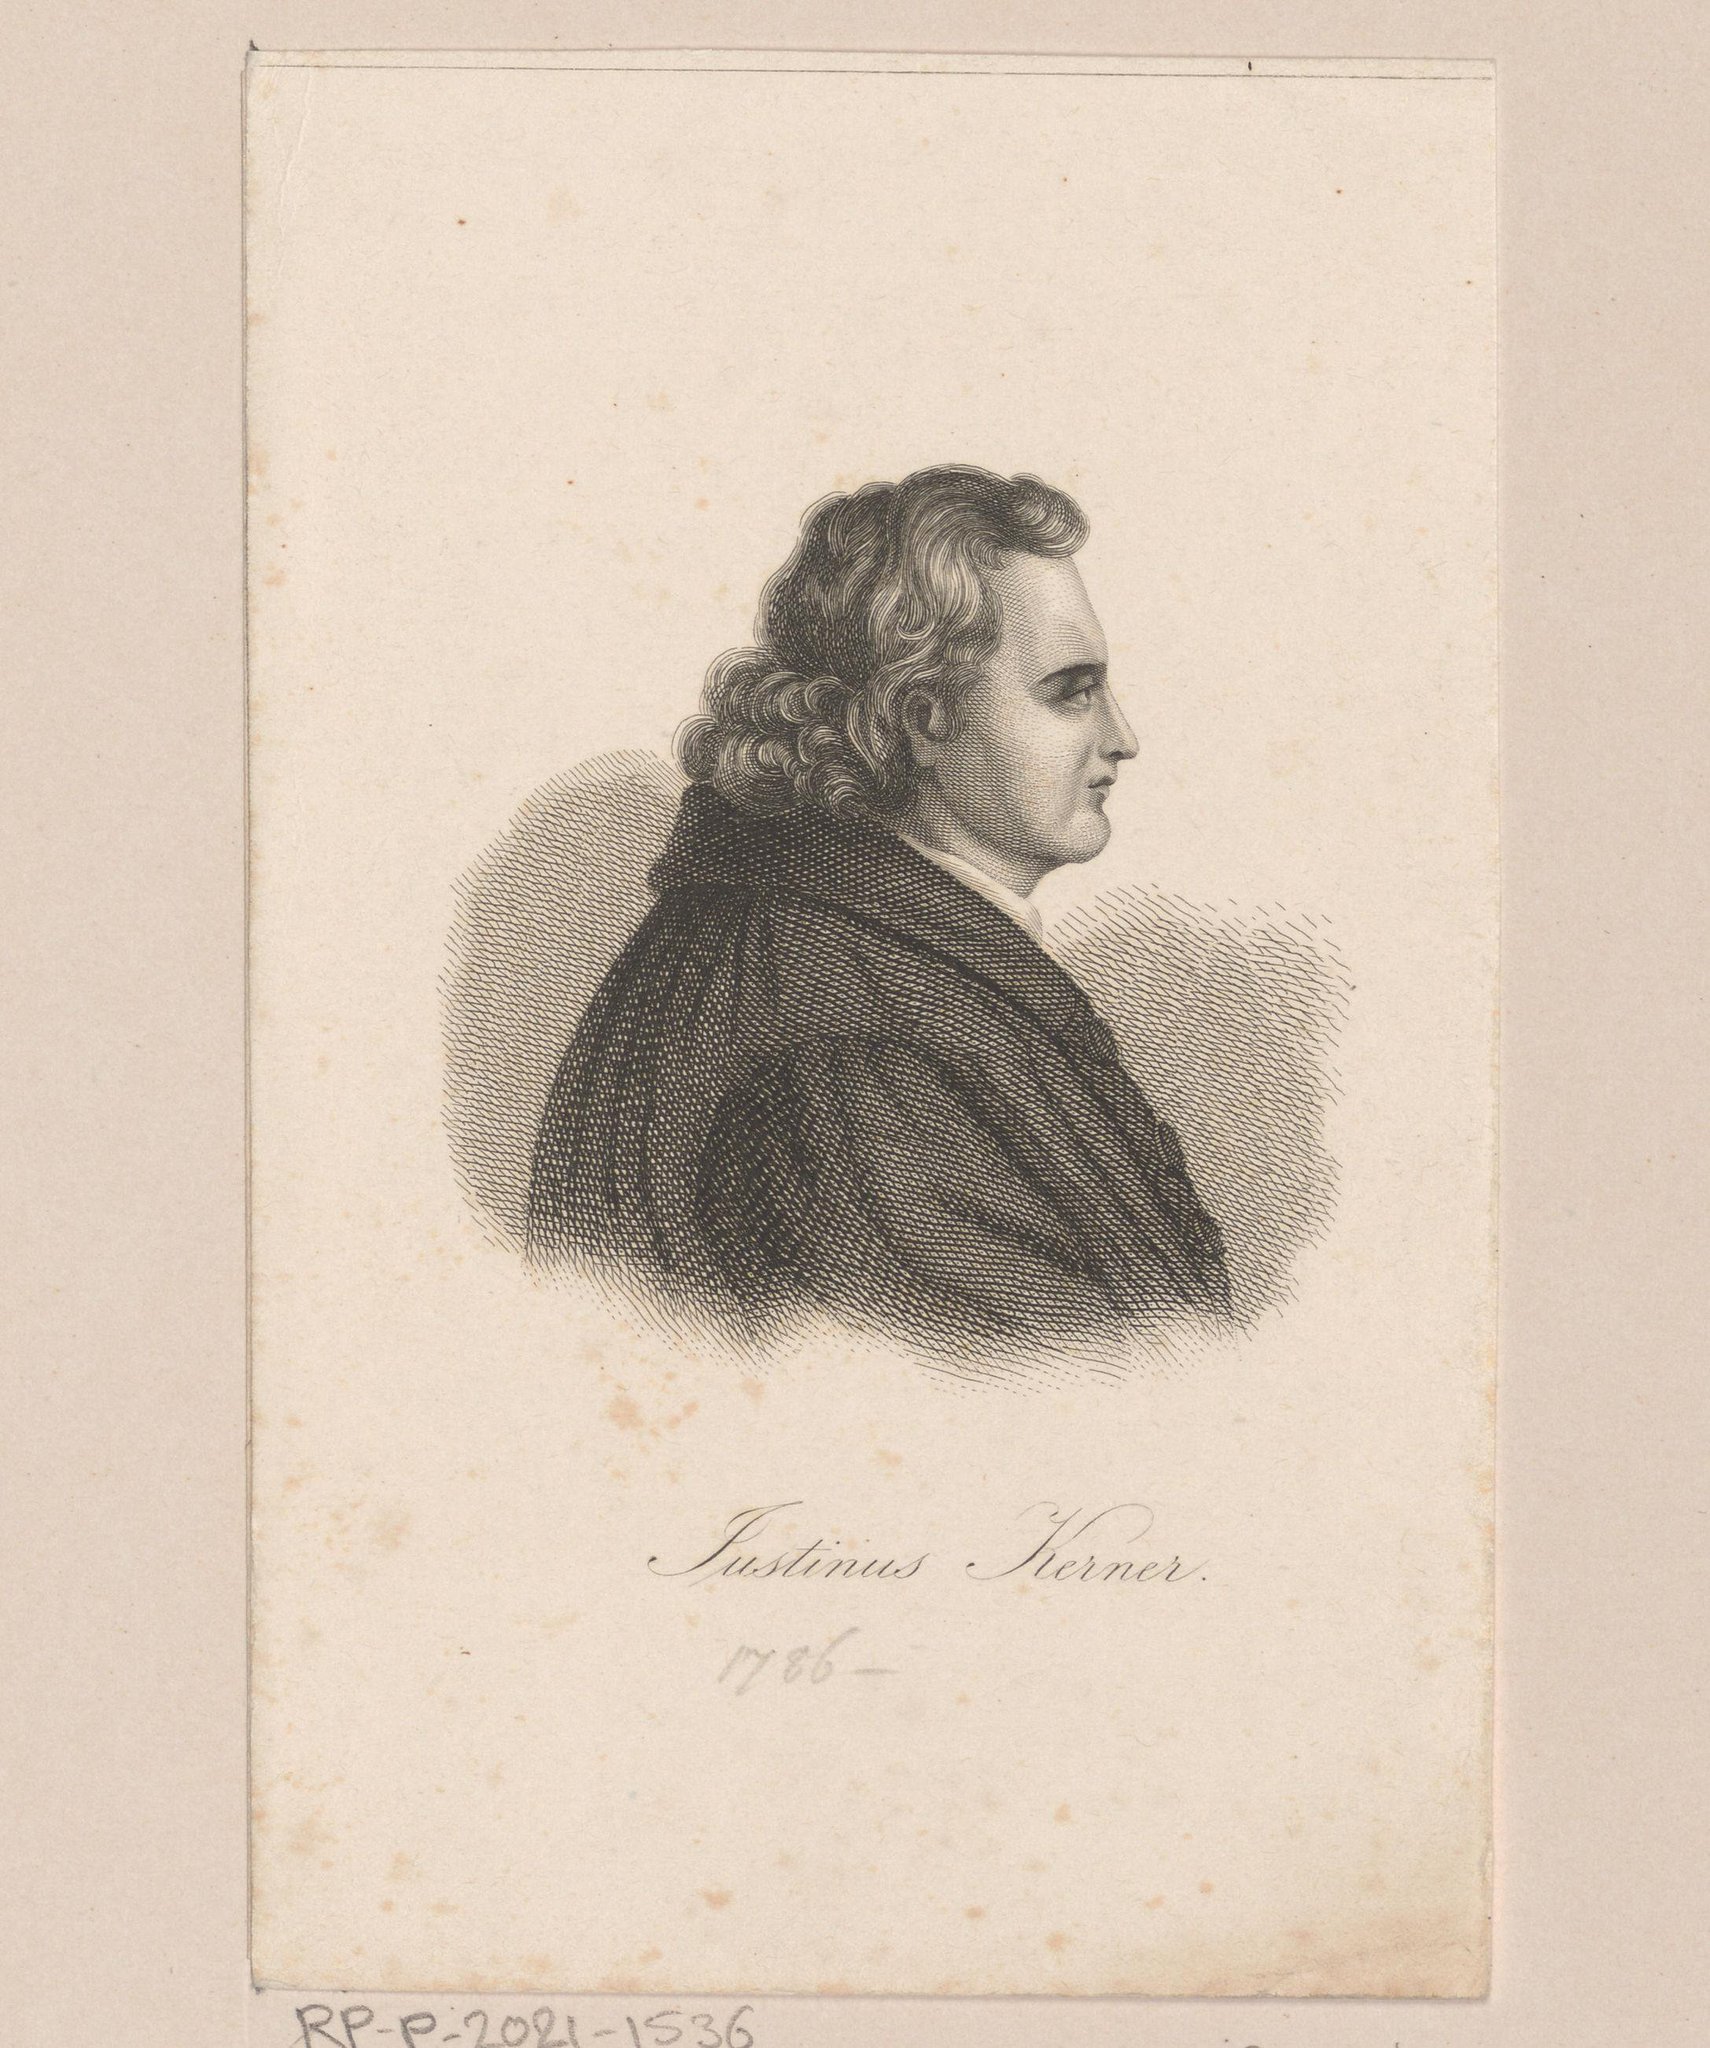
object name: print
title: Portret van Justinus Andreas Christian Kerner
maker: Anonymous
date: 1830-1879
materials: paper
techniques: etching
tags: historical persons